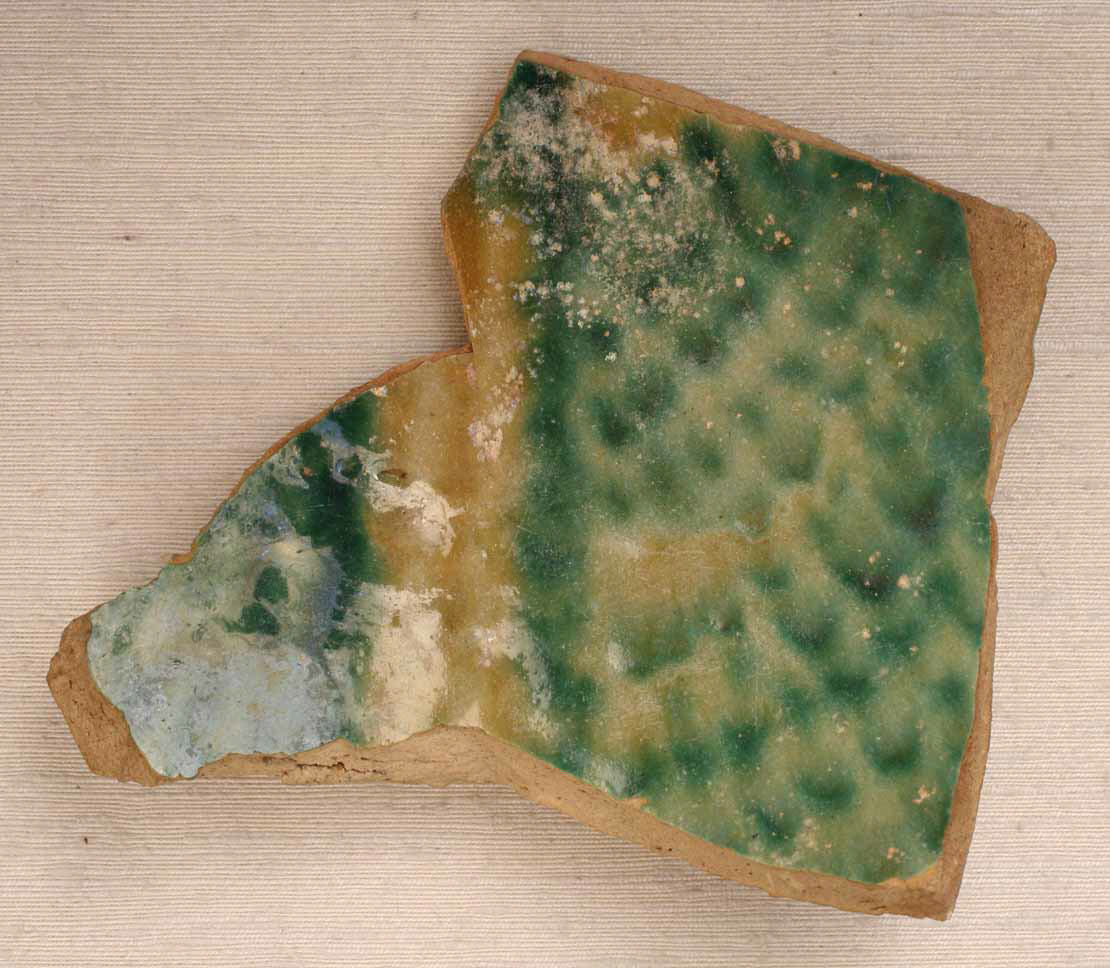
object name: fragment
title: Fragments of Splashed Ceramic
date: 801-900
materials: earthenware, glaze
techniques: painting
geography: iraq